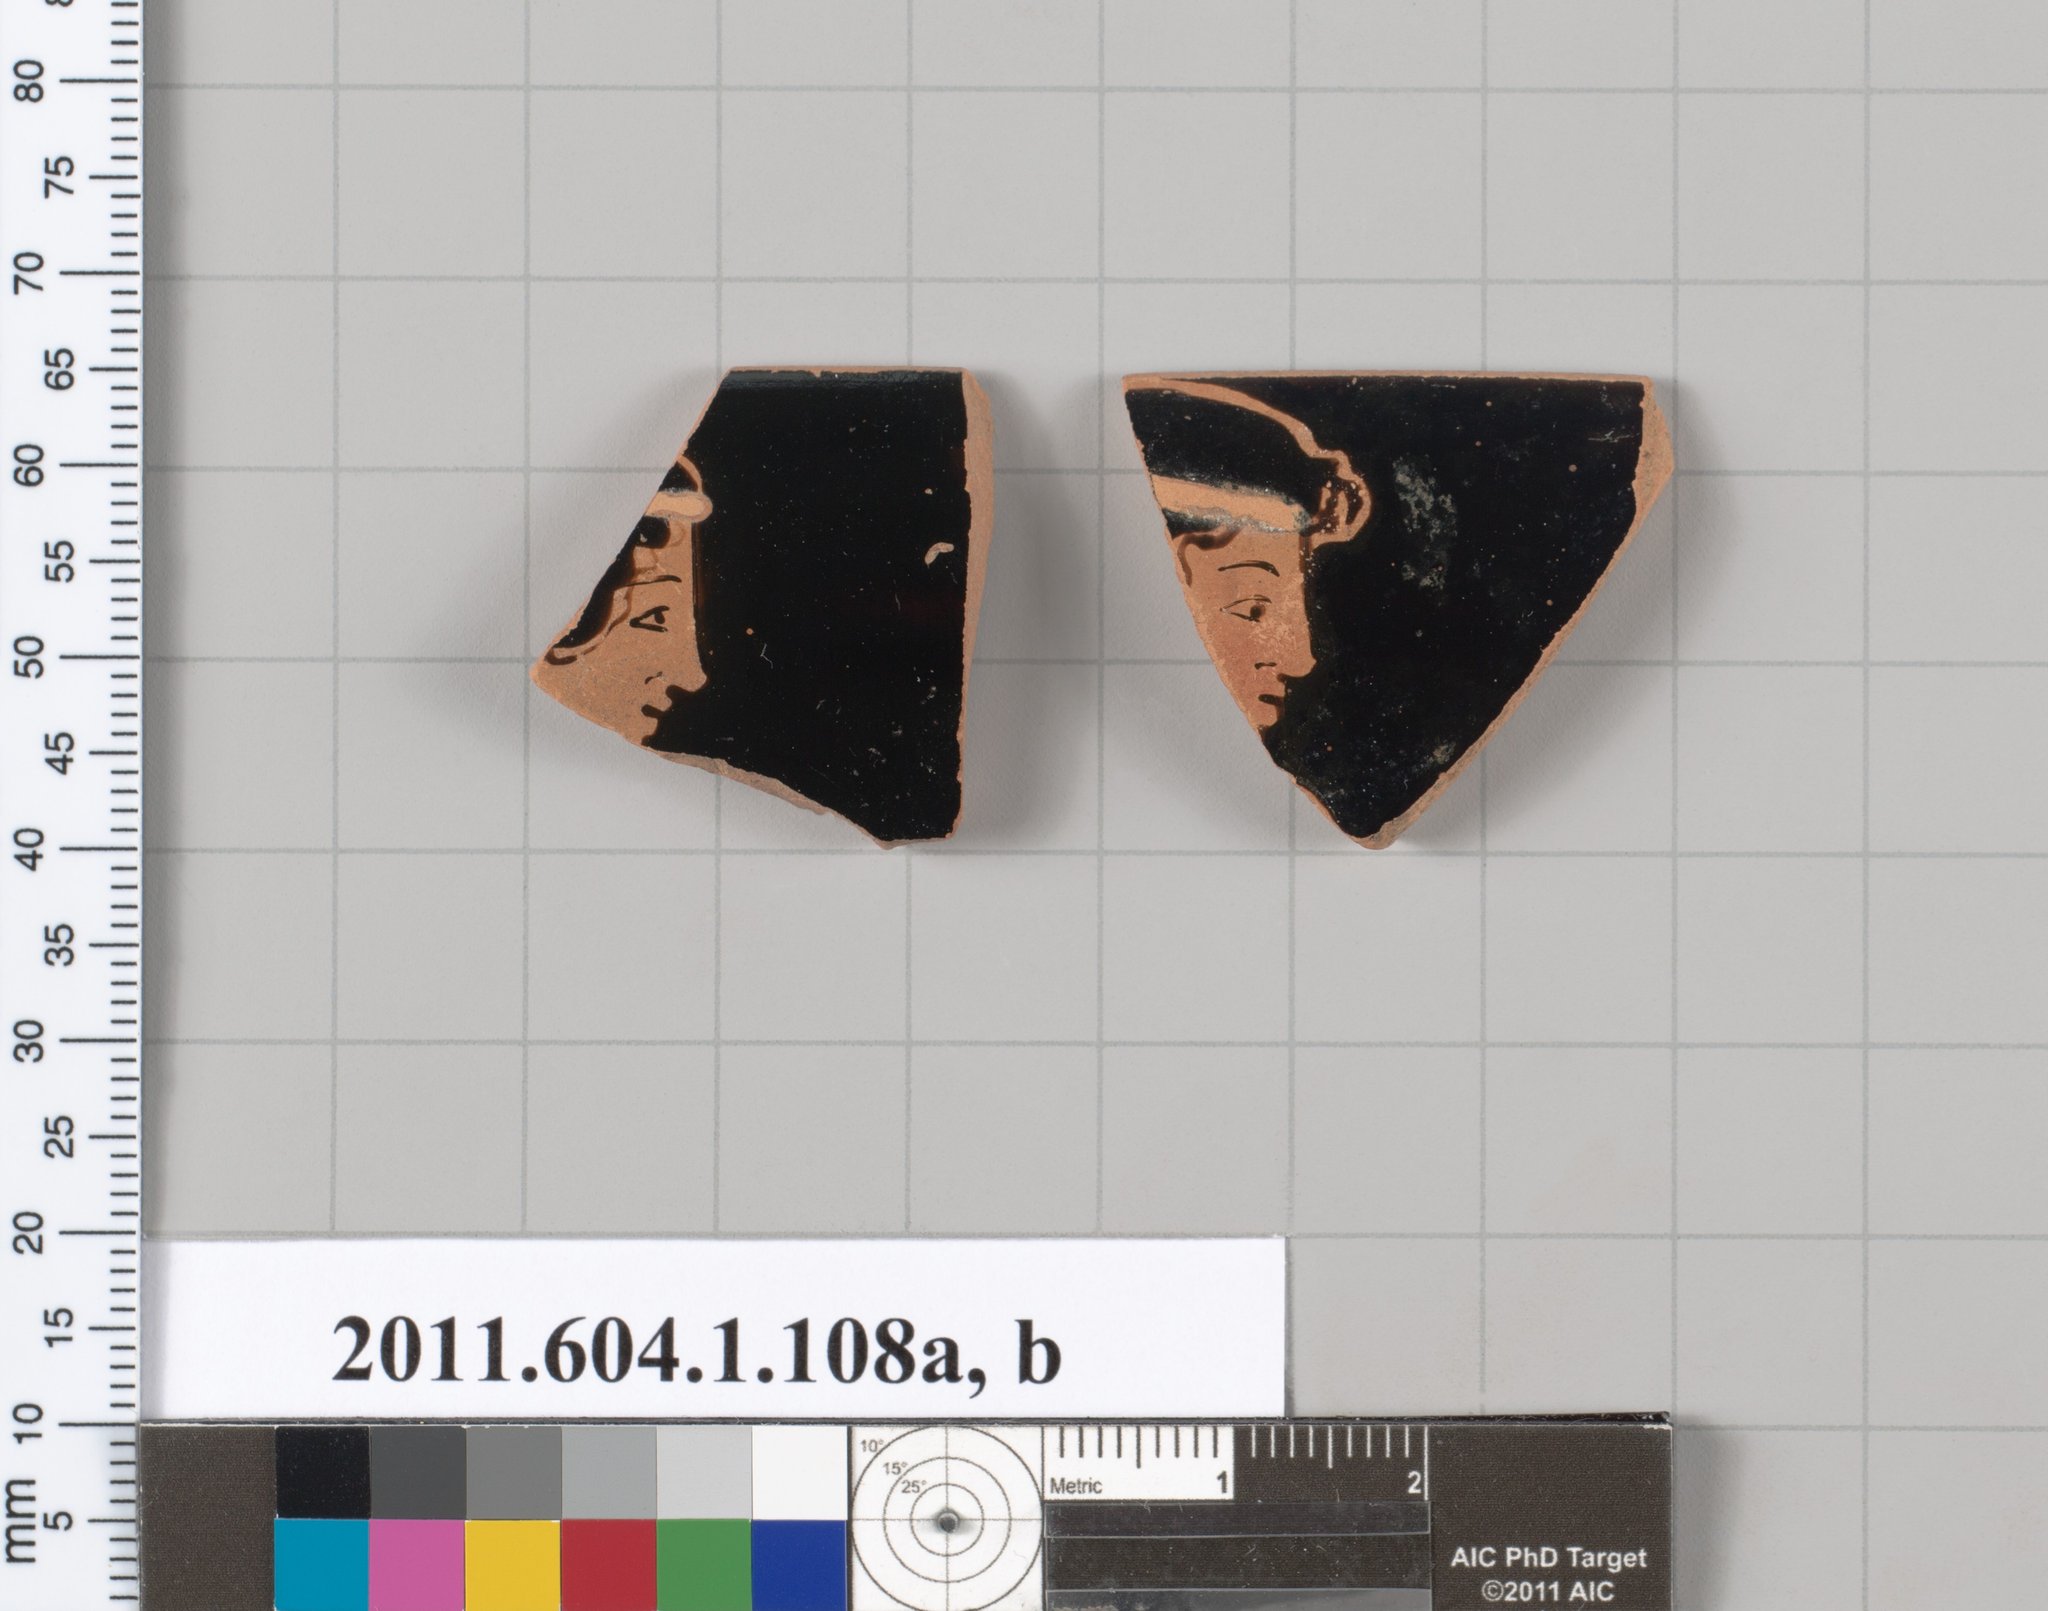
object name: kylix fragment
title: Terracotta rim fragments of a kylix (drinking cup)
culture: greek, attic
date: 470-450 BCE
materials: terracotta